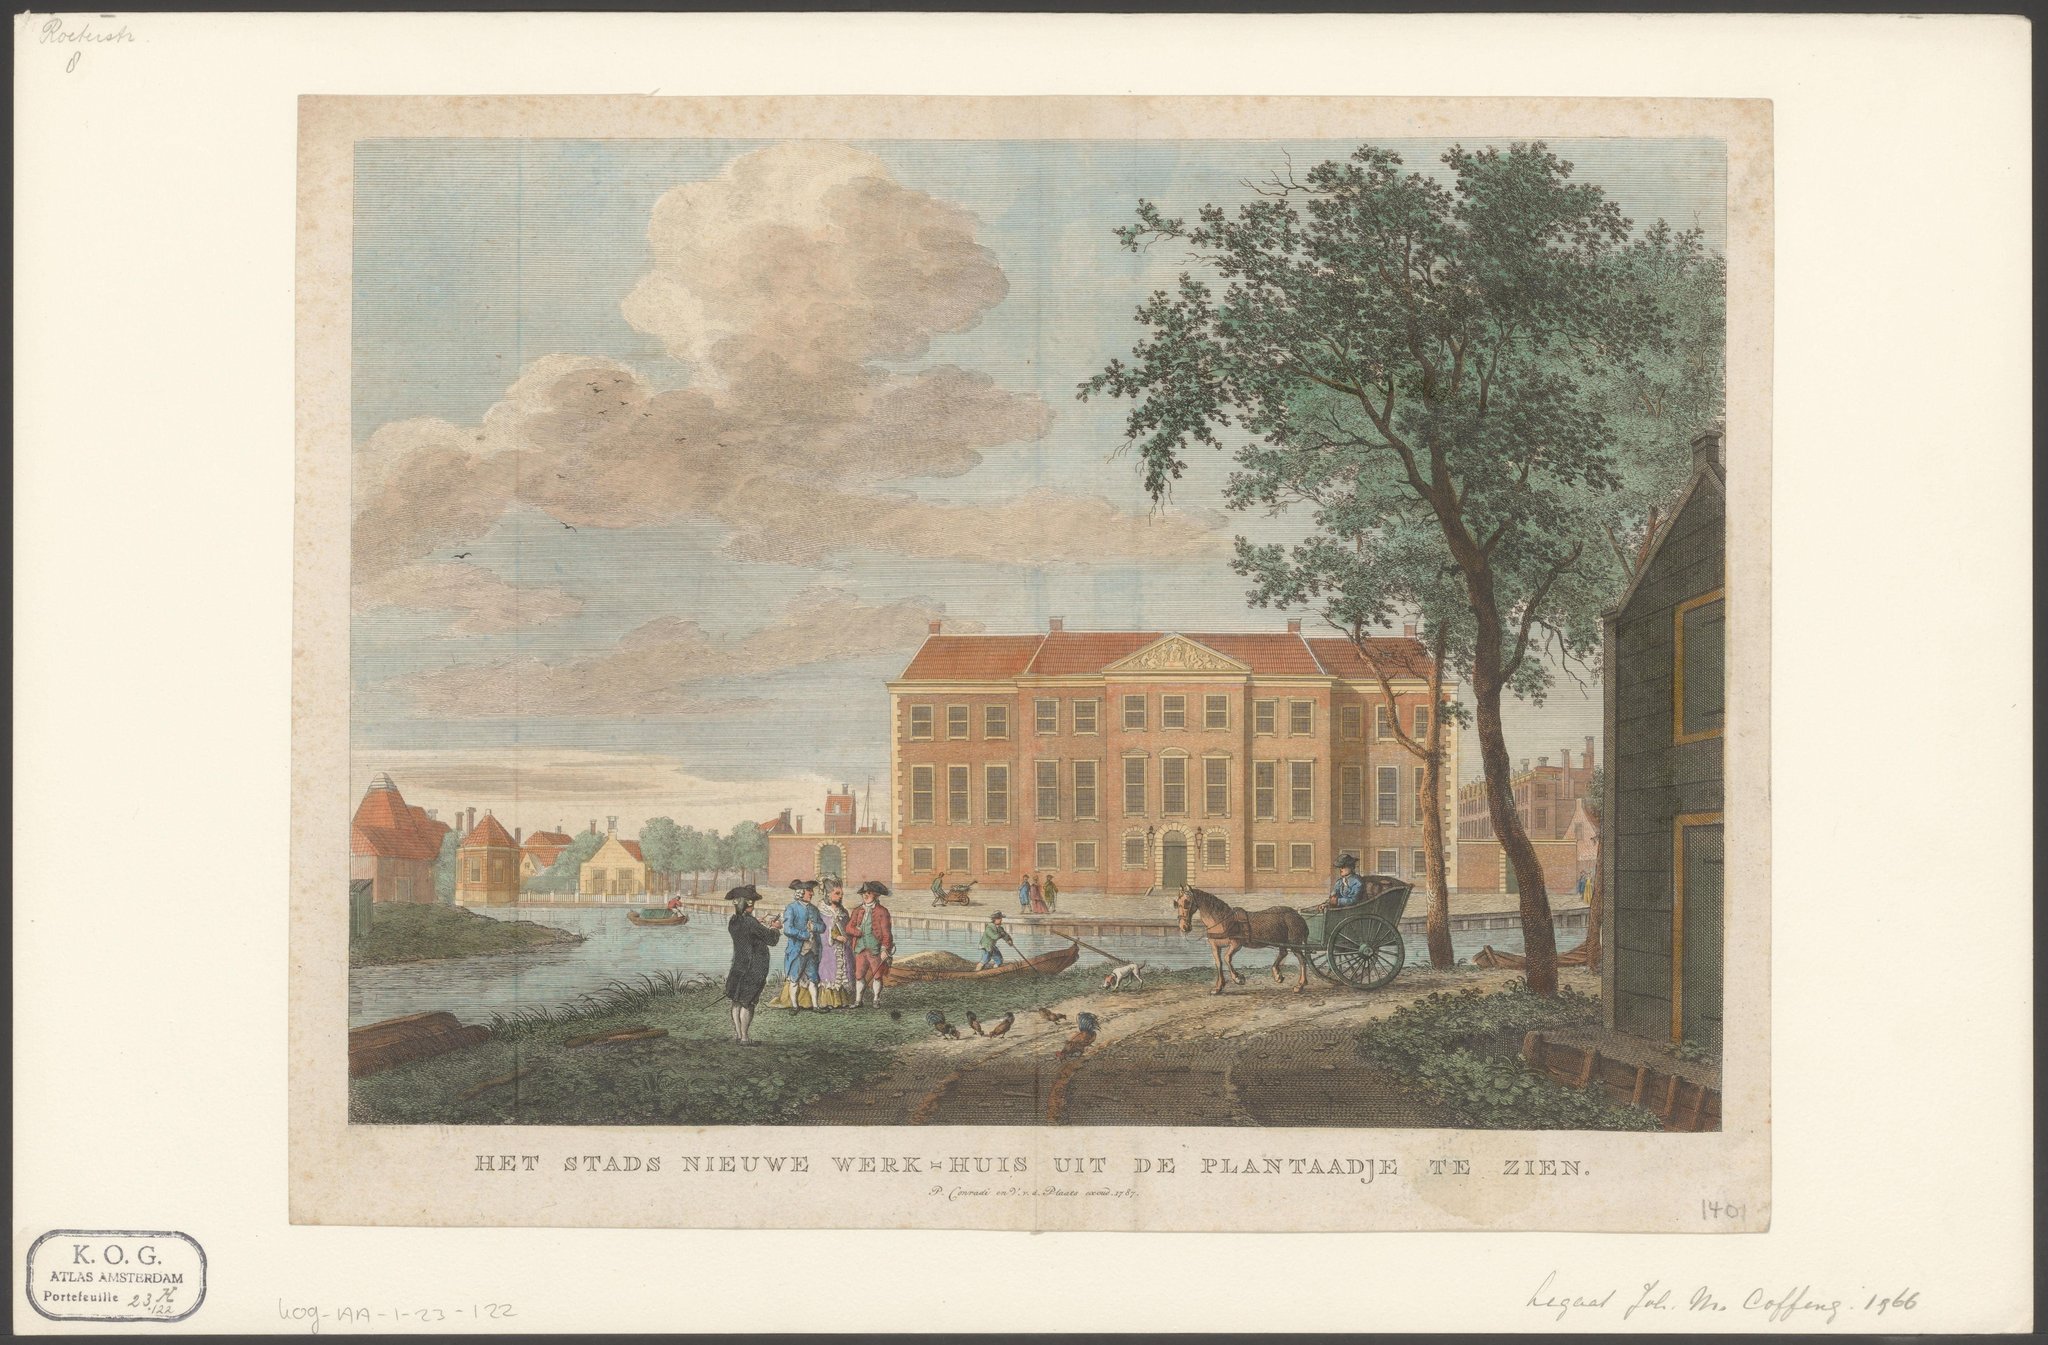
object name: print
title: Gezicht op het Nieuwe Werkhuis te Amsterdam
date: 1787-1788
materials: paper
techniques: etching, hand coloring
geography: amsterdam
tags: prison, jail, canals, waters (in city), workhouse, penal camp, penitentiary, chain gang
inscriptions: collector's mark: Lugt 1641b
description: Prent mogelijk uit: Stijl, Simon. Amsterdam, in zyne geschiedenissen, voorregten, koophandel, gebouwen, kerkenstaat, schoolen, schutterye, gilden en regeeringe, beschreeven. Om te dienen ten vervolge op het werk van Jan Wagenaar (…). 10 dln. Amsterdam en Harlingen: Petrus Conradi en Volkert van der Plaats, 1788, dl. 4. De prent werd eerder uitgegeven door Pierre Fouquet als onderdeel van de zogenaamde Atlas van Fouquet: stadsgezichten van Amsterdam naar tekeningen van verschillende kunstenaars. Deze prenten werden aanvankelijk (vanaf ca. 1760) los verkocht en later (1783) samengebonden gepubliceerd. In 1805 werden de prenten nogmaals door Evert Maaskamp uitgegeven.